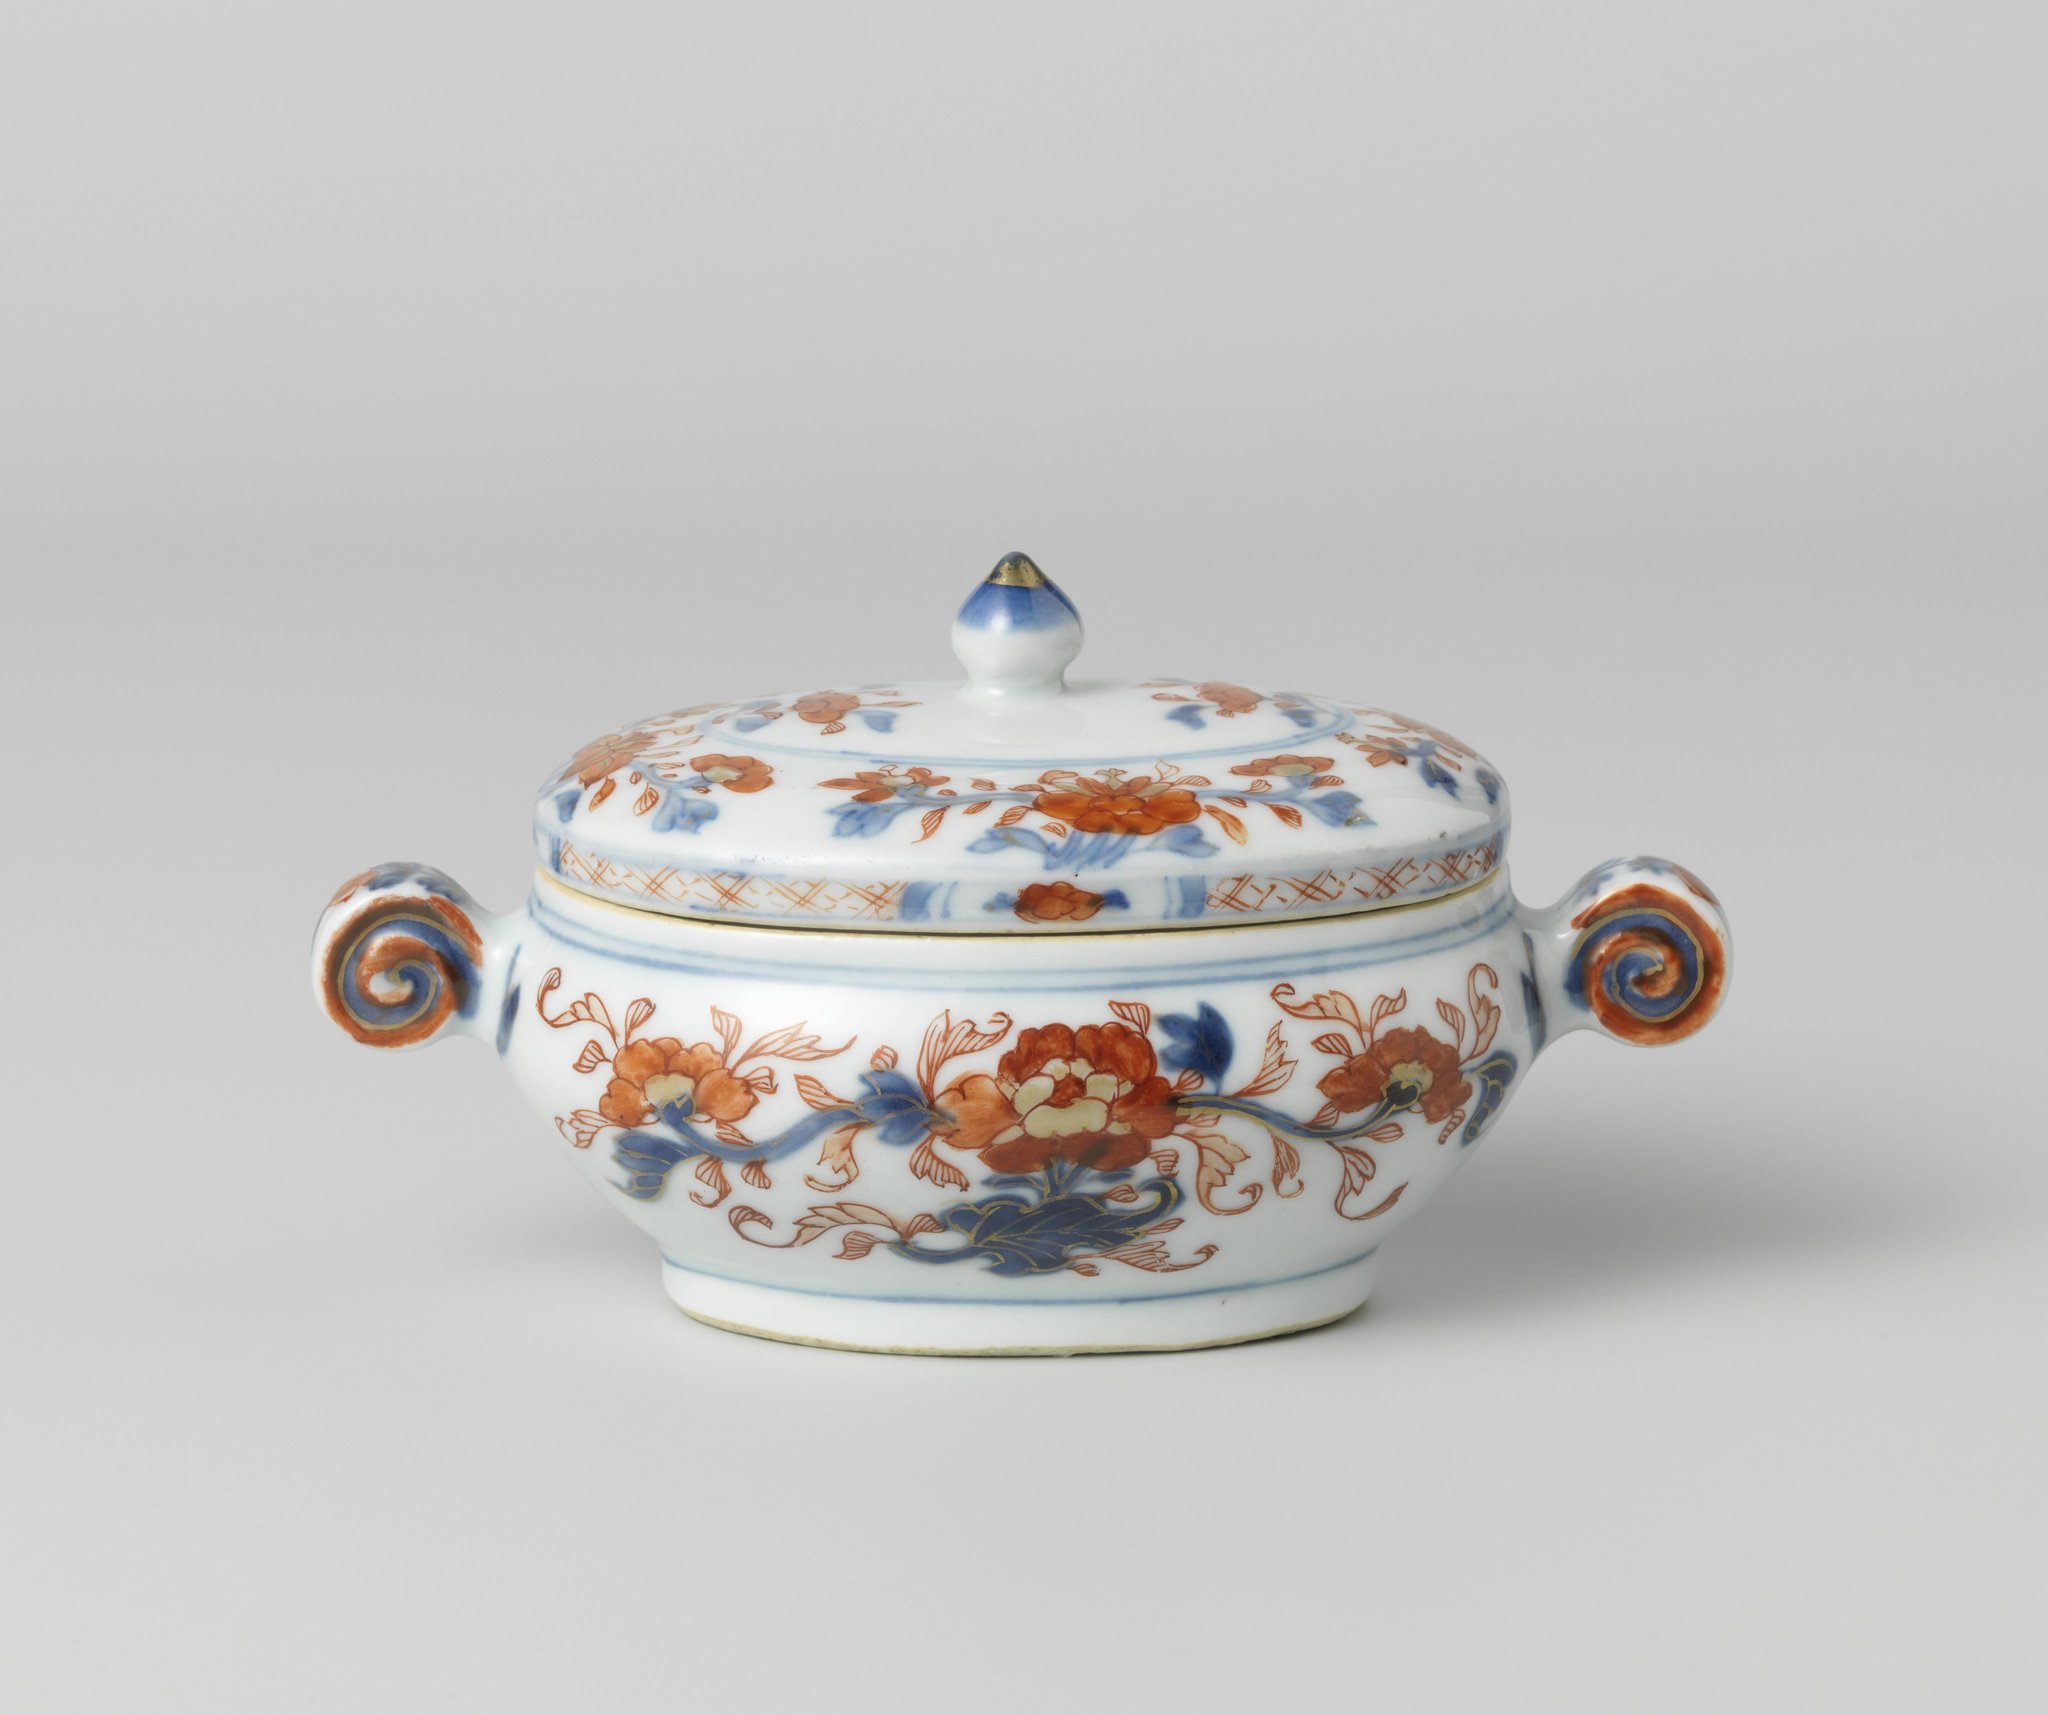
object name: tureen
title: Tureen with flower sprays and two vertical scroll handles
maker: Anonymous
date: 1725-1849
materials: cobalt, glaze, gold, paint, porcelain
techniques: firing, forming, gilding, turning, vitrification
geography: china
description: Deksel van terrine van porselein, beschilderd in onderglazuur blauw en op het glazuur rood en goud. Vier bloemtakken en twee bloemtakken in een medaillon afgebeeld; op de rand servetwerk afgewisseld met een bloemtak in een cartouche. Chinees Imari.